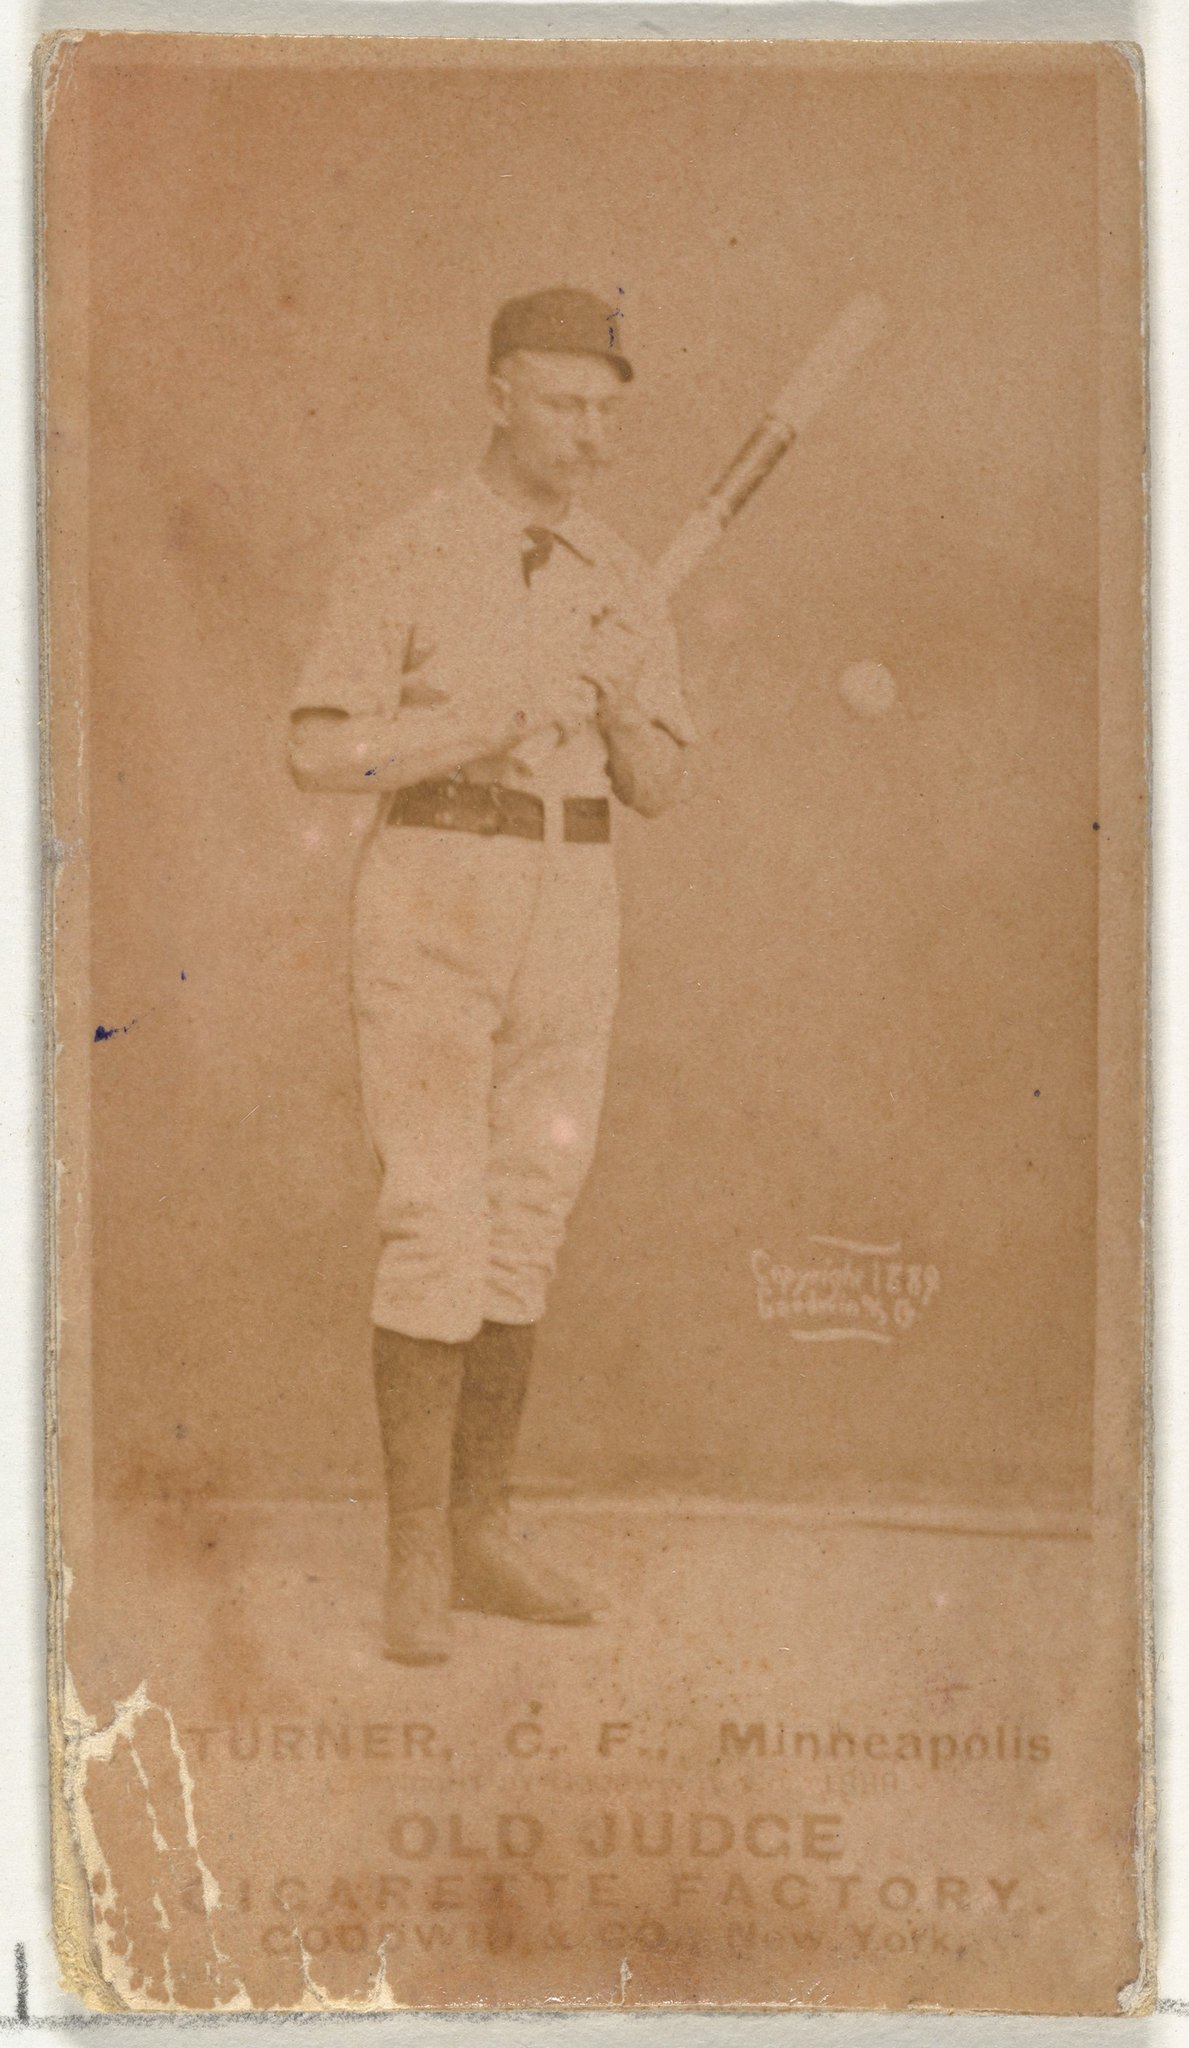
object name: baseball card, photograph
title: Thomas Turner, Center Field, Minneapolis, from the Old Judge series (N172) for Old Judge Cigarettes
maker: goodwin & company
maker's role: publisher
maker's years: 1850-1950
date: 1889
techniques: albumen silver print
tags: men,portraits,baseball,athletes